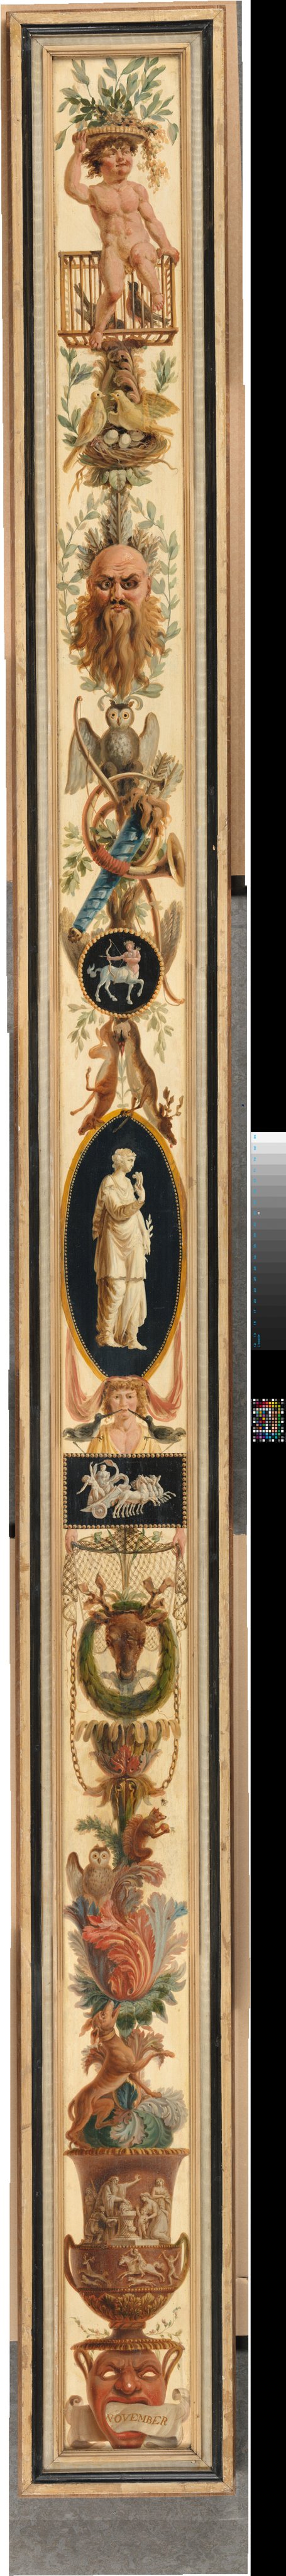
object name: painting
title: November, with the Sign of Sagittarius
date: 1790-1791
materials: oil, panel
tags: ornament ~ grotesque, november ~ other concepts (+ with signs or personifications of the planets together with zodiacal signs)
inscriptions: inscription: ‘November’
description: Negen maanden met de tekens van de dierenriem: November met het teken van de boogschutter. Maakt deel uit van een groep decoraties met grotesken afkomstig uit het huis van J.A. Brentano aan de Herengracht. Waarschijnlijk vervaardigd naar ontwerpen van Giambattista Maderna.